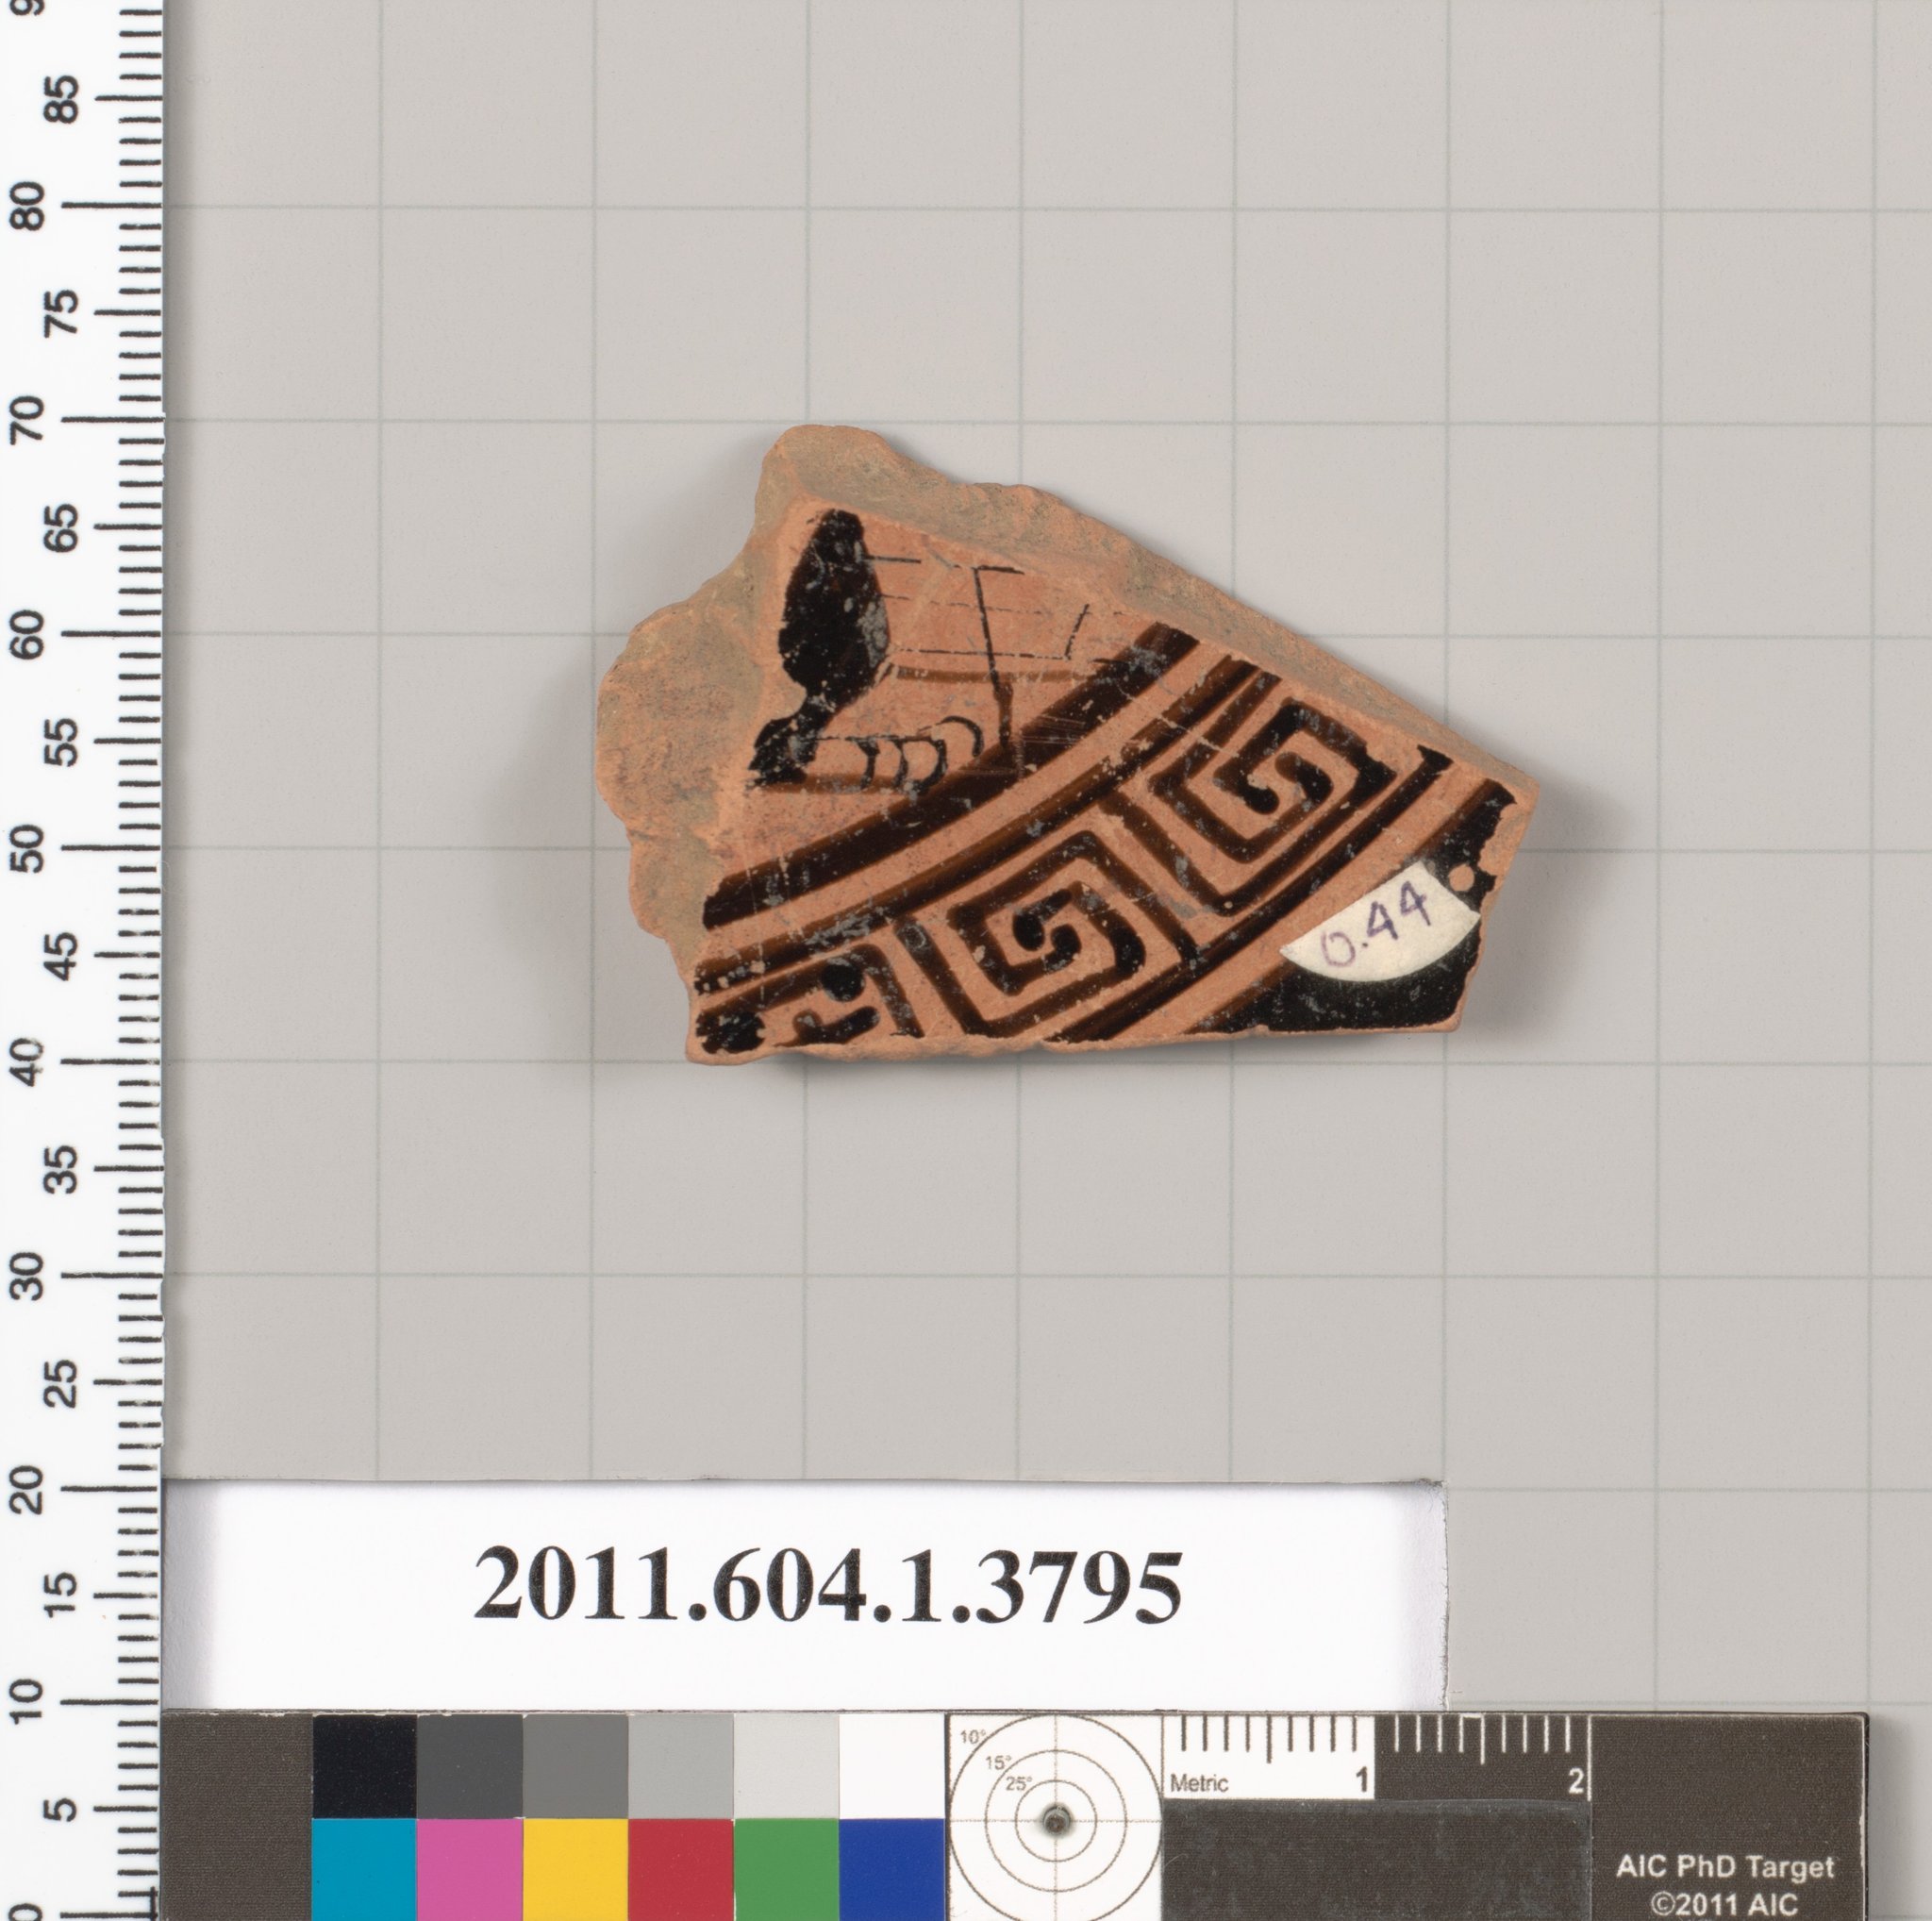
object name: kylix fragment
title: Terracotta fragment of a kylix (drinking cup)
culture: greek, attic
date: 460-450 BCE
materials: terracotta